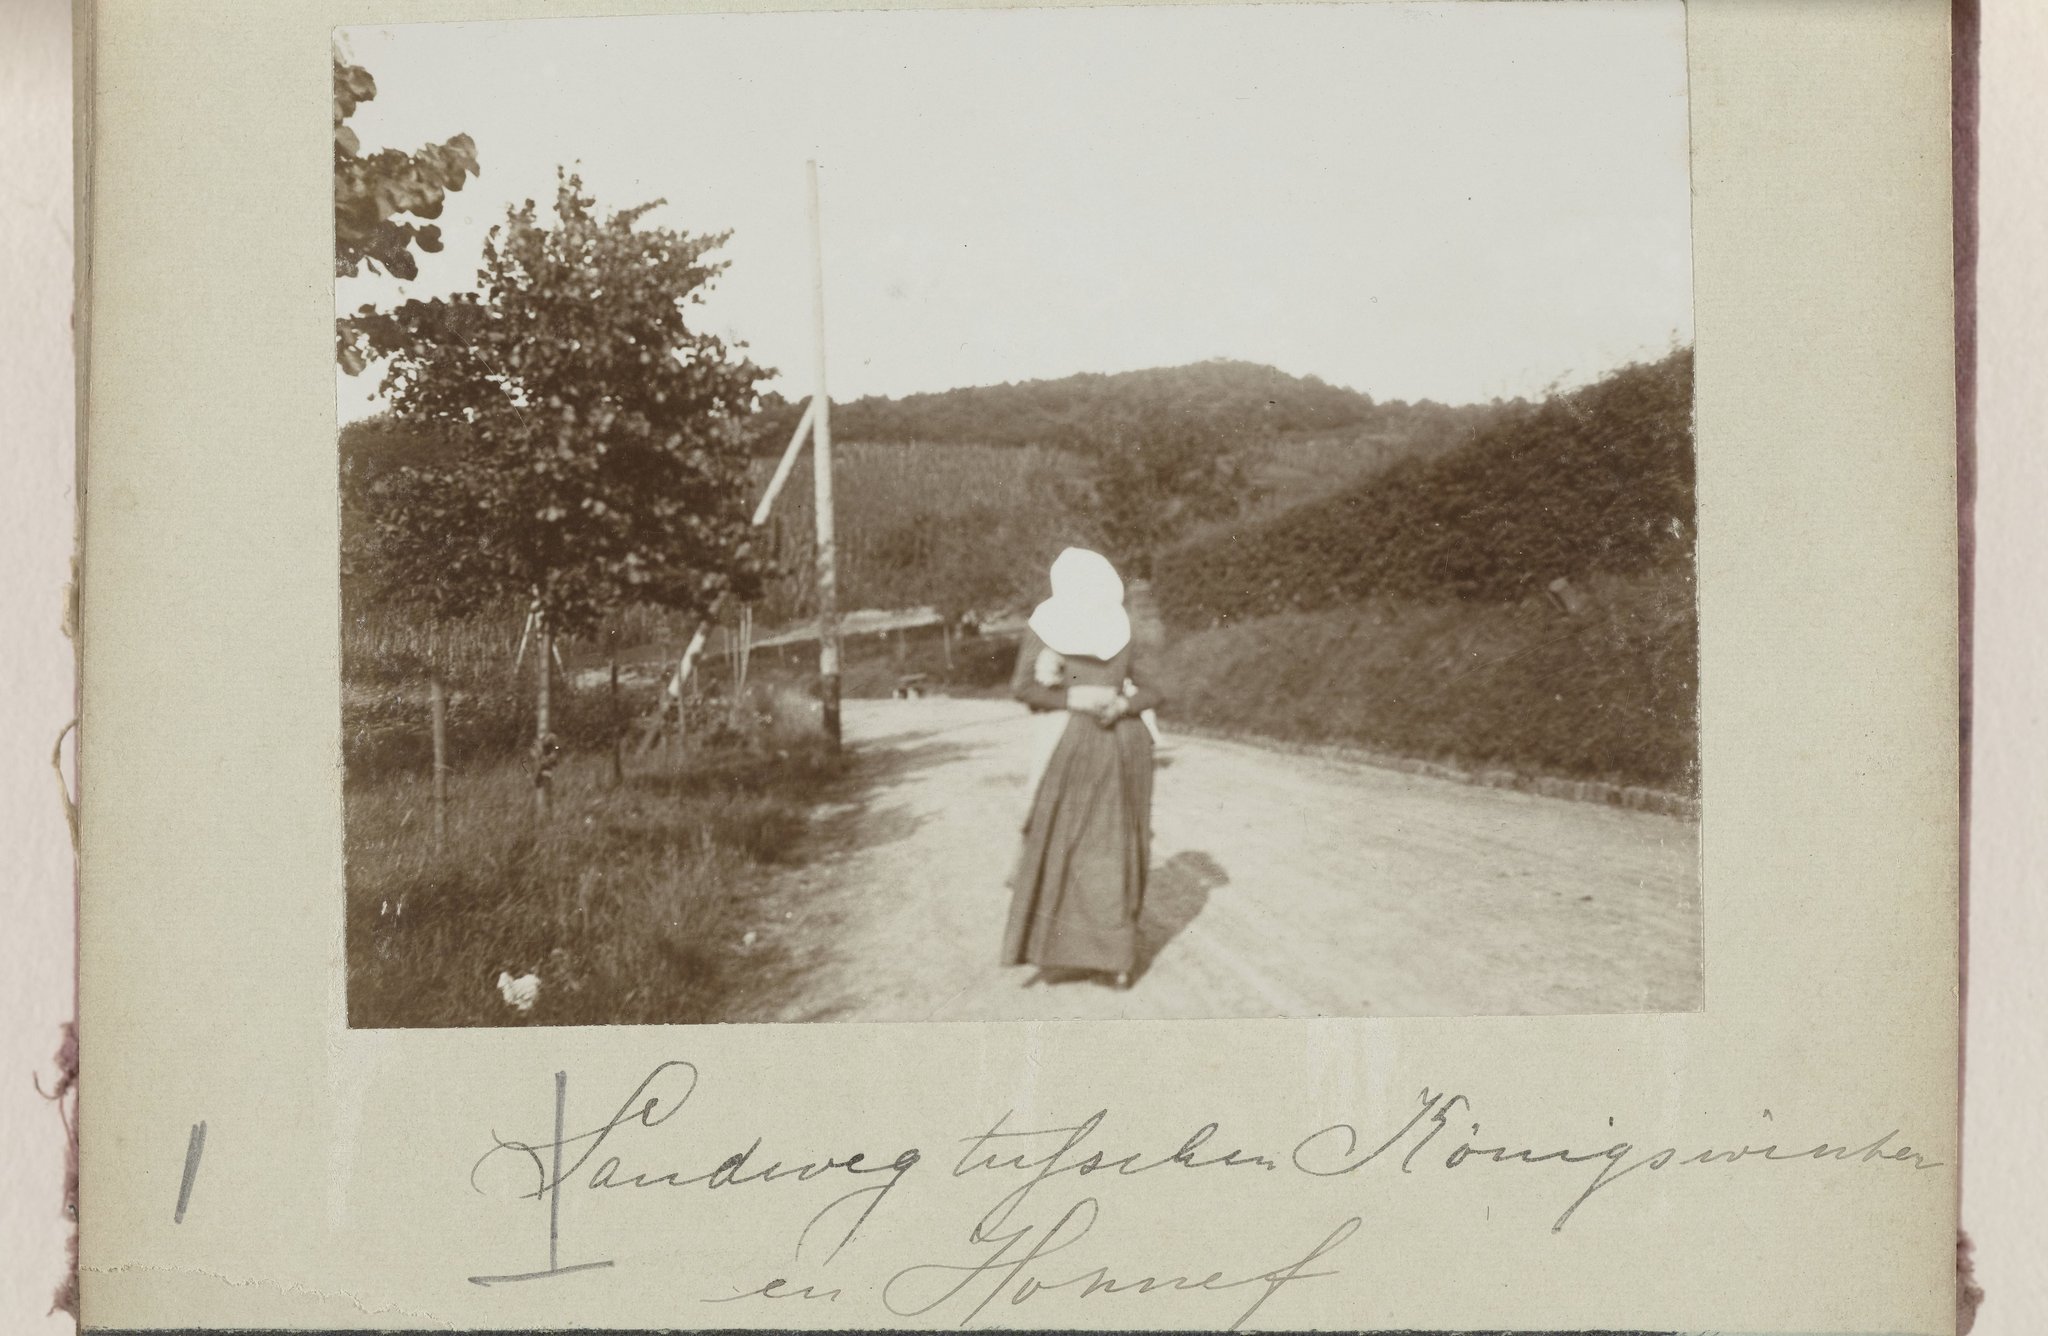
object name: photograph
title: Vrouw lopend op een zandweg tussen Königswinter en Bad Honnef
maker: david vermeulen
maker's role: fotograaf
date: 1895-1905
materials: paper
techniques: collodion silver print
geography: north rhine-westphalia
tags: adult woman, strolling, road, path